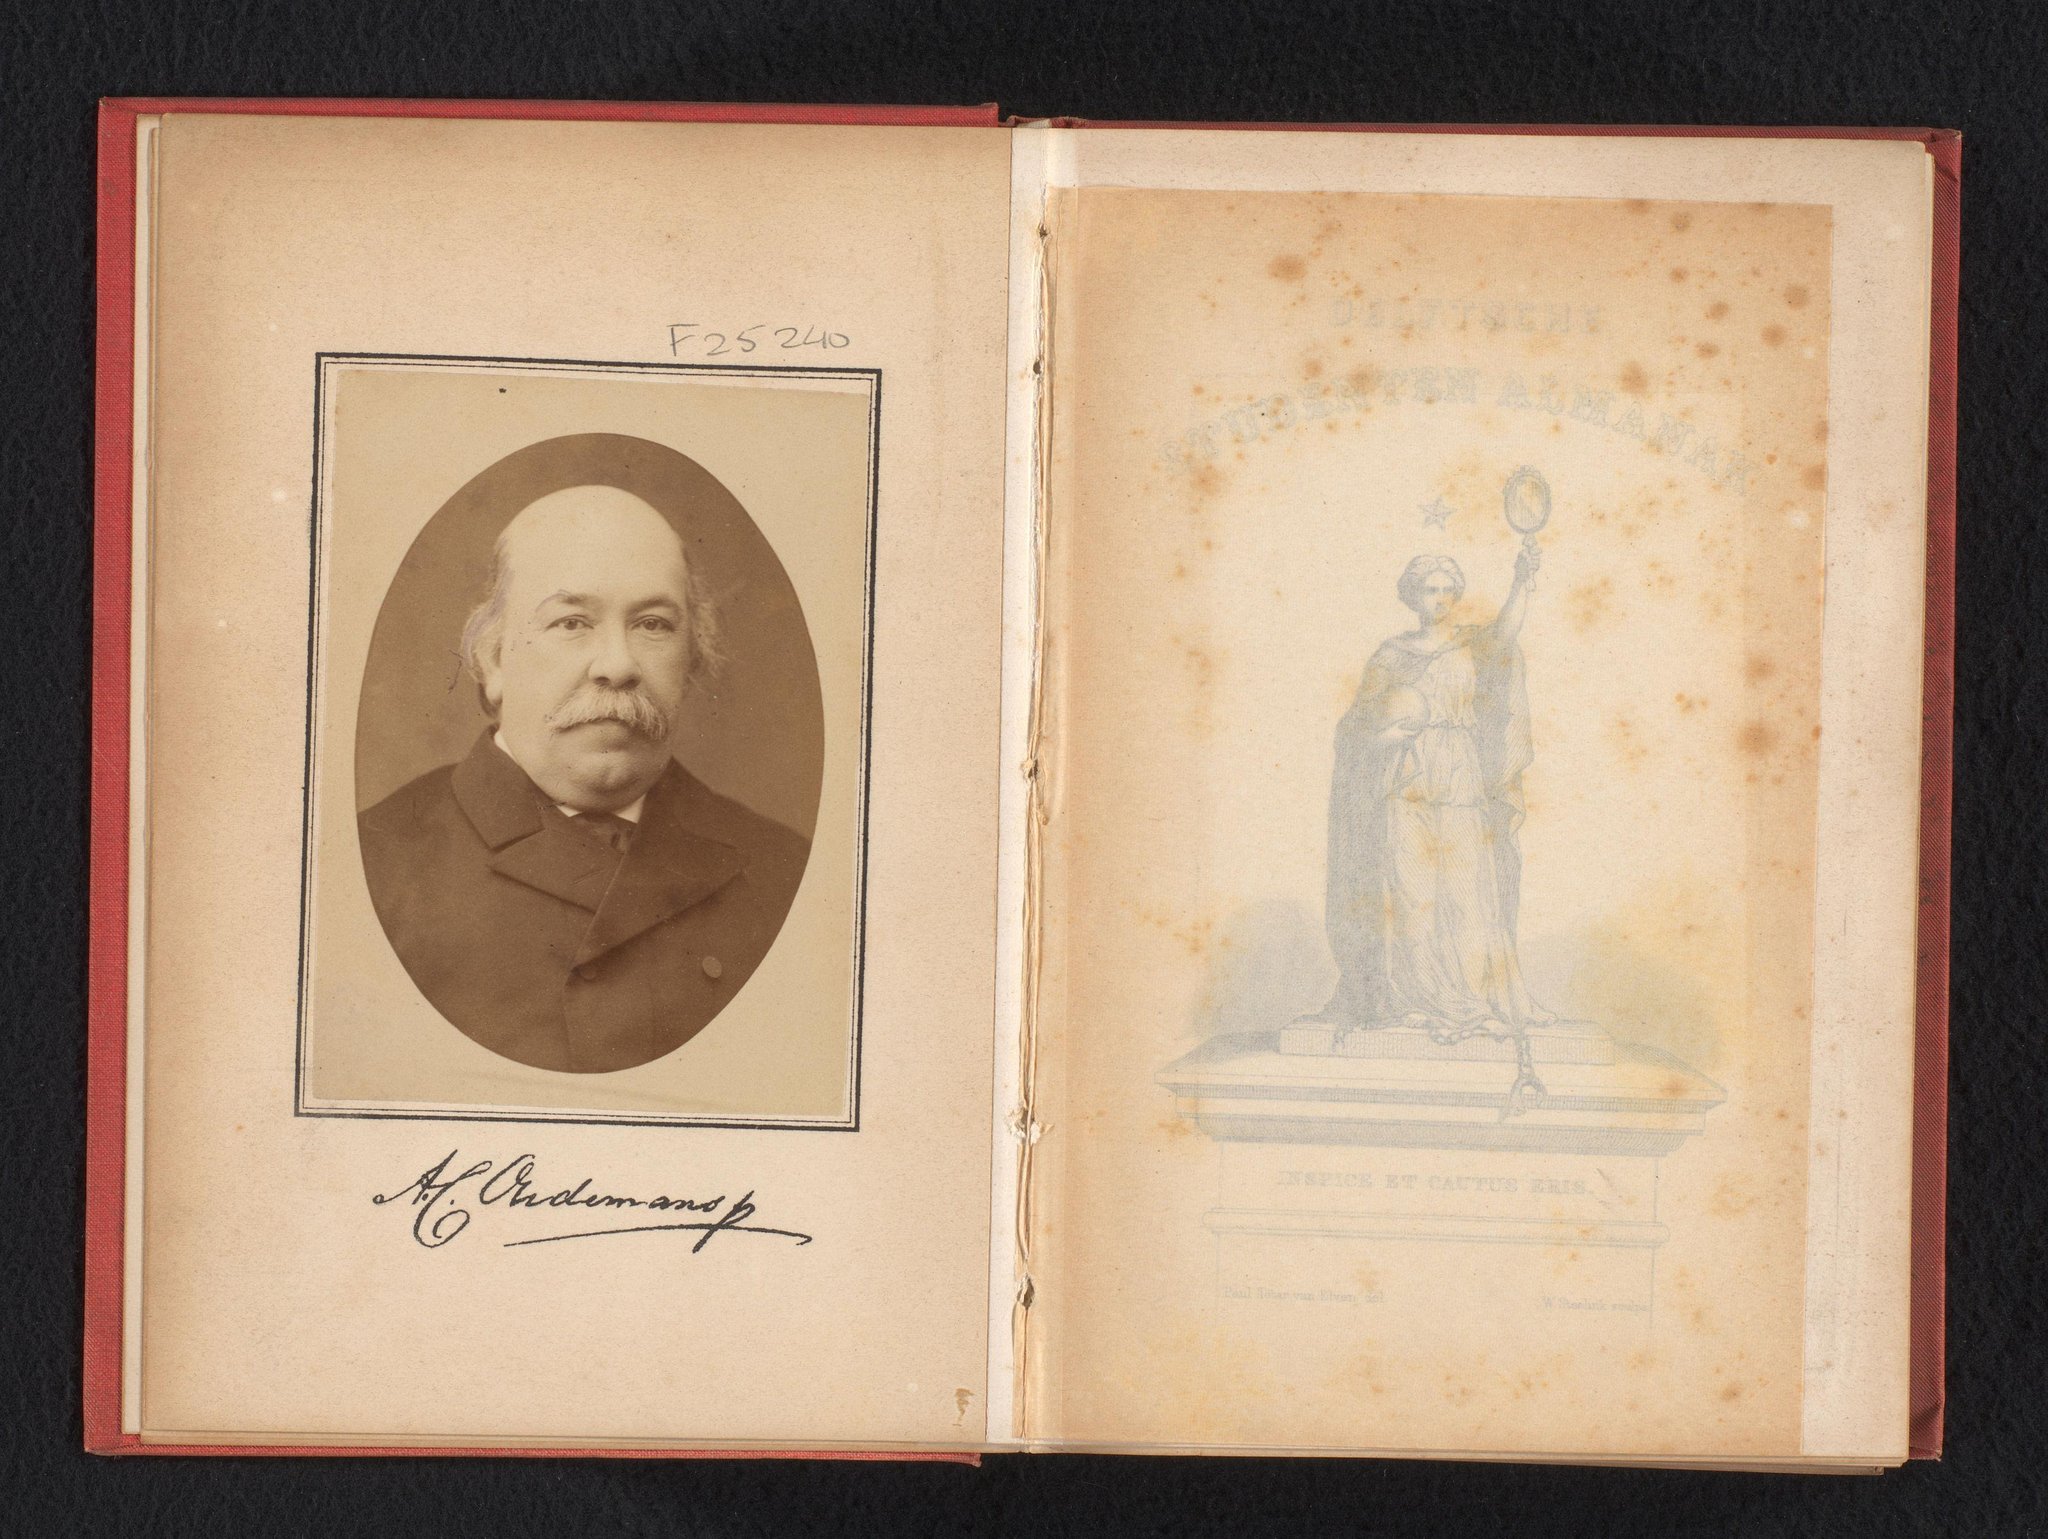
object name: photograph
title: Portret van A.C. Oudemans Jr., hoogleraar scheikunde aan de Polytechnische School Delft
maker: Anonymous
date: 1886-1887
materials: paper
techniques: albumen print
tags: amsterdam, delft, historical persons, professor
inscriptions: signature: ‘A.C. Oudemans jr’